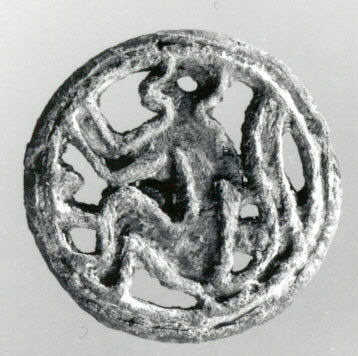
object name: stamp seal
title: Openwork stamp seal: seated monkey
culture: bactria-margiana archaeological complex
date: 2333-1668 BCE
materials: copper alloy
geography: bactria-margiana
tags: monkeys